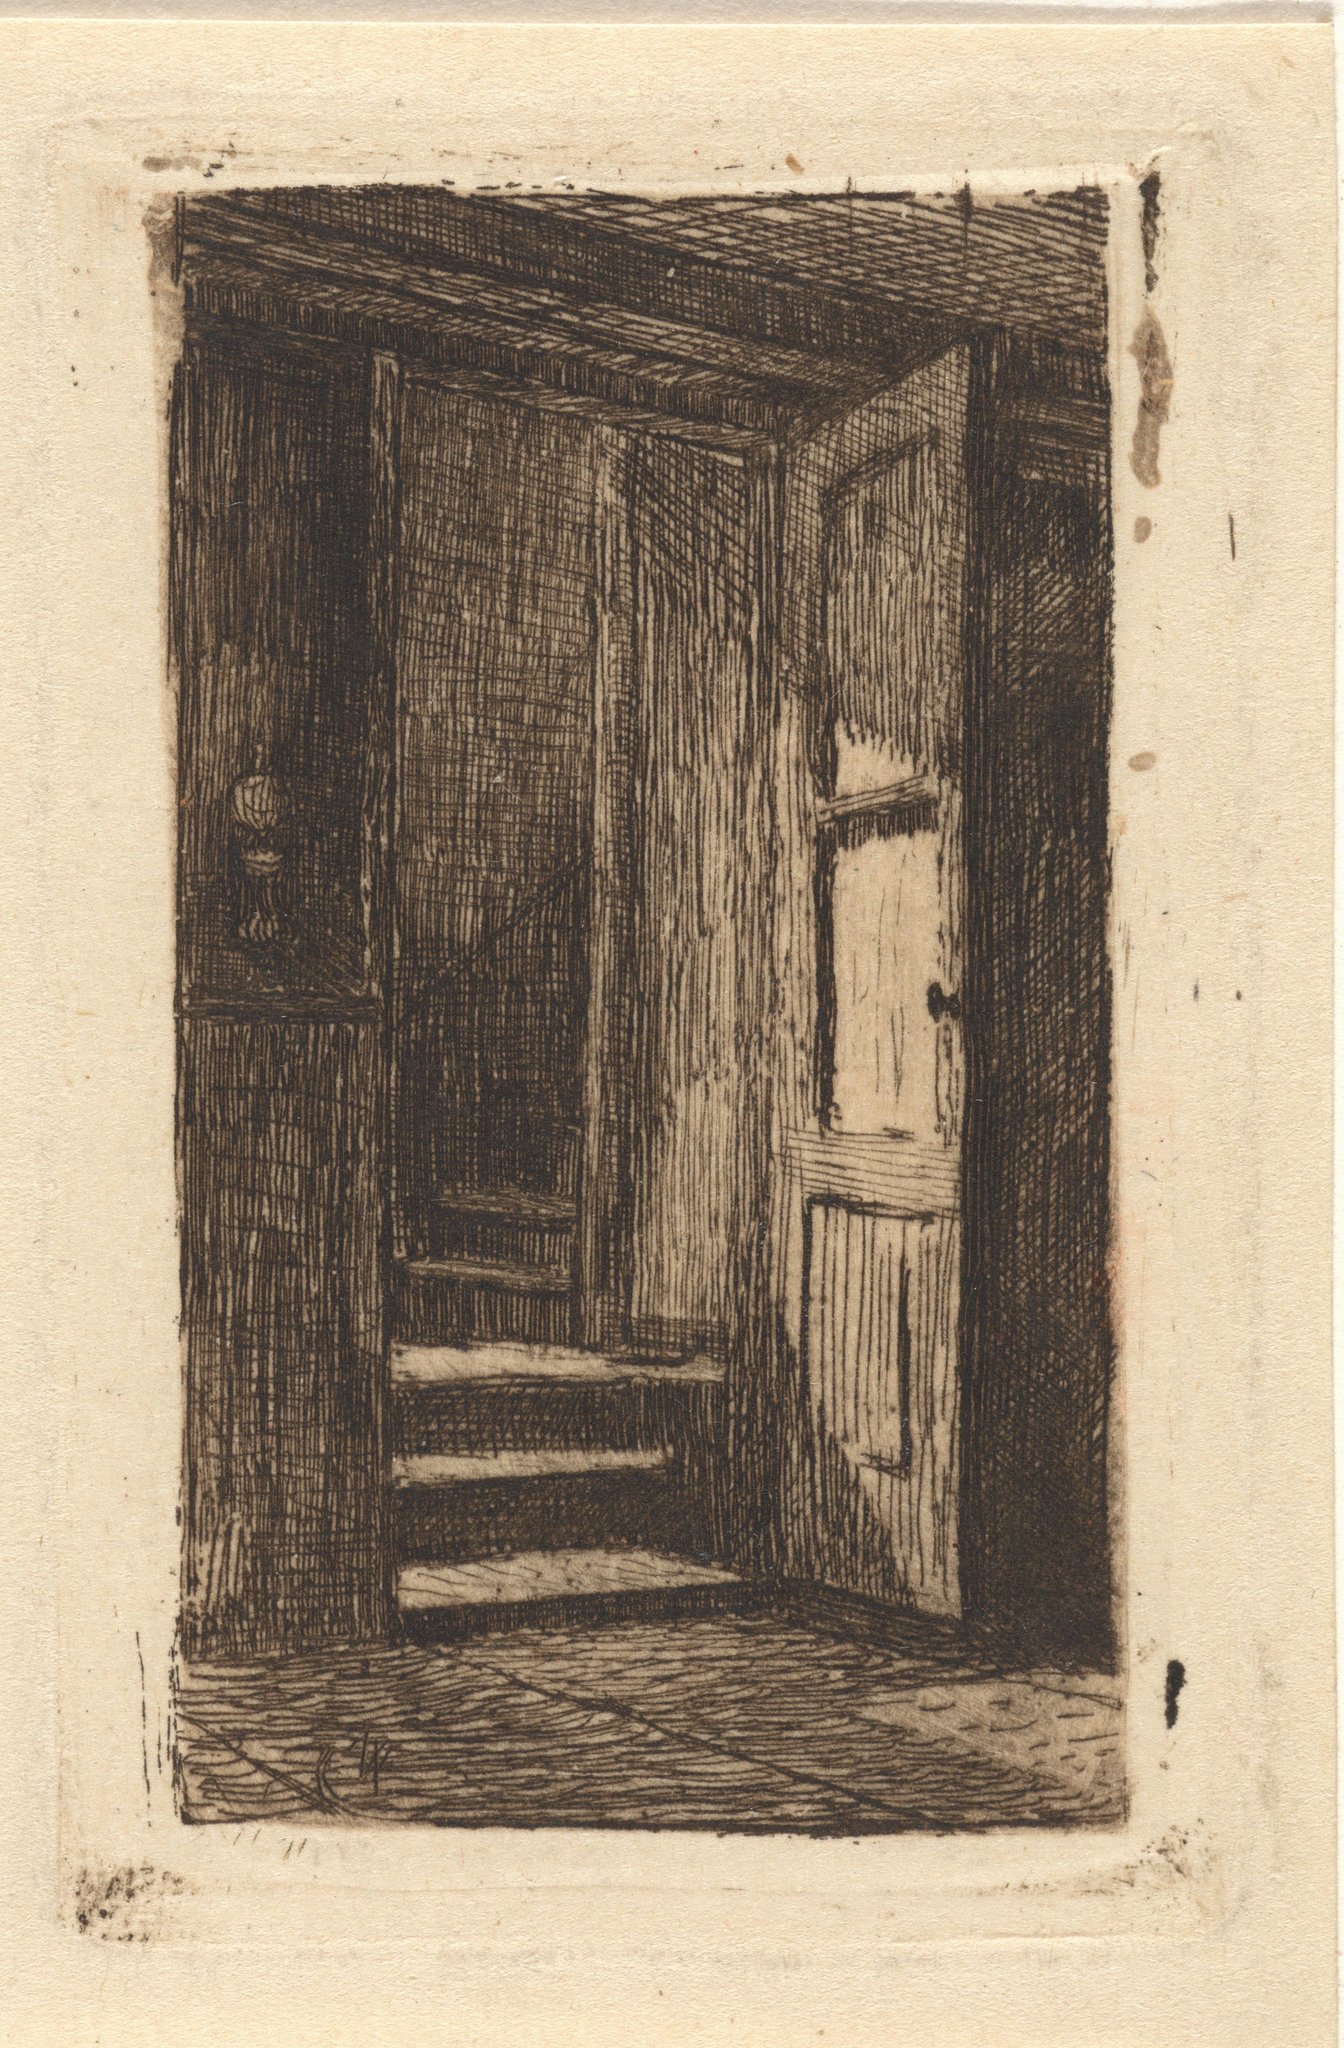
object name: print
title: Openstaande deur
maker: willem steelink (ii)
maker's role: draughtsman, print maker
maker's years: 1856-1928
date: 1866-1928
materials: paper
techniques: etching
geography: netherlands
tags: open door, staircase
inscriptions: collector's mark: Lugt 2228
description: Een openstaande deur met een trap erachter.